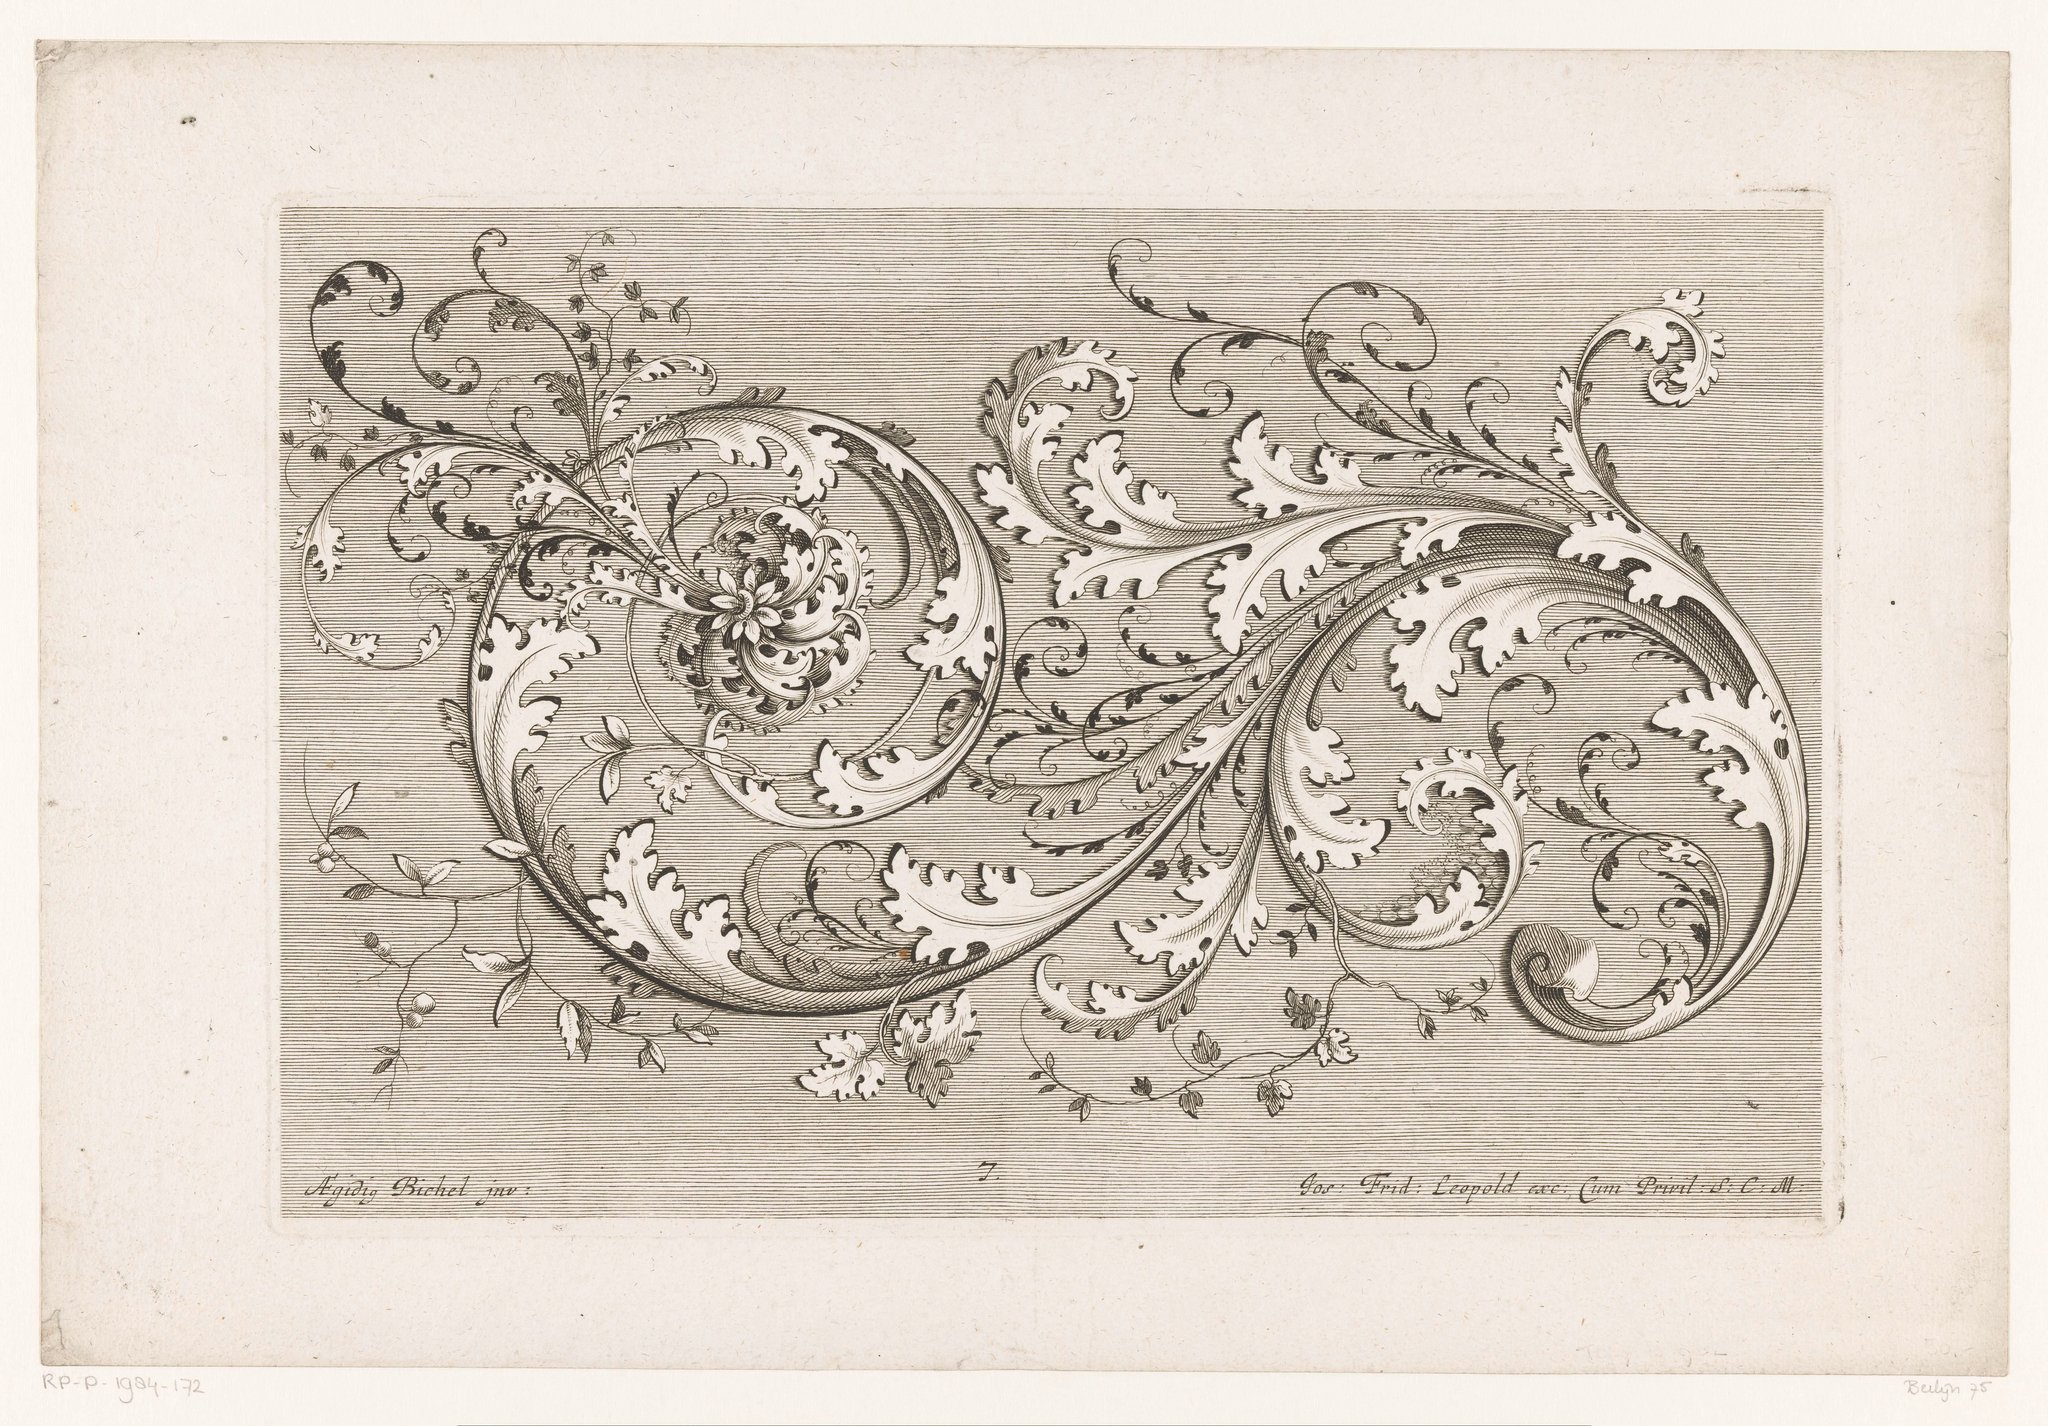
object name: print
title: Allerhand Inventiones von Frantzösischem Laub-Werkh (...)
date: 1697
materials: paper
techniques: engraving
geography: augsburg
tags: acanthus ~ ornament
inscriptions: collector's mark: Lugt 2228, collector's mark: Lugt 2760